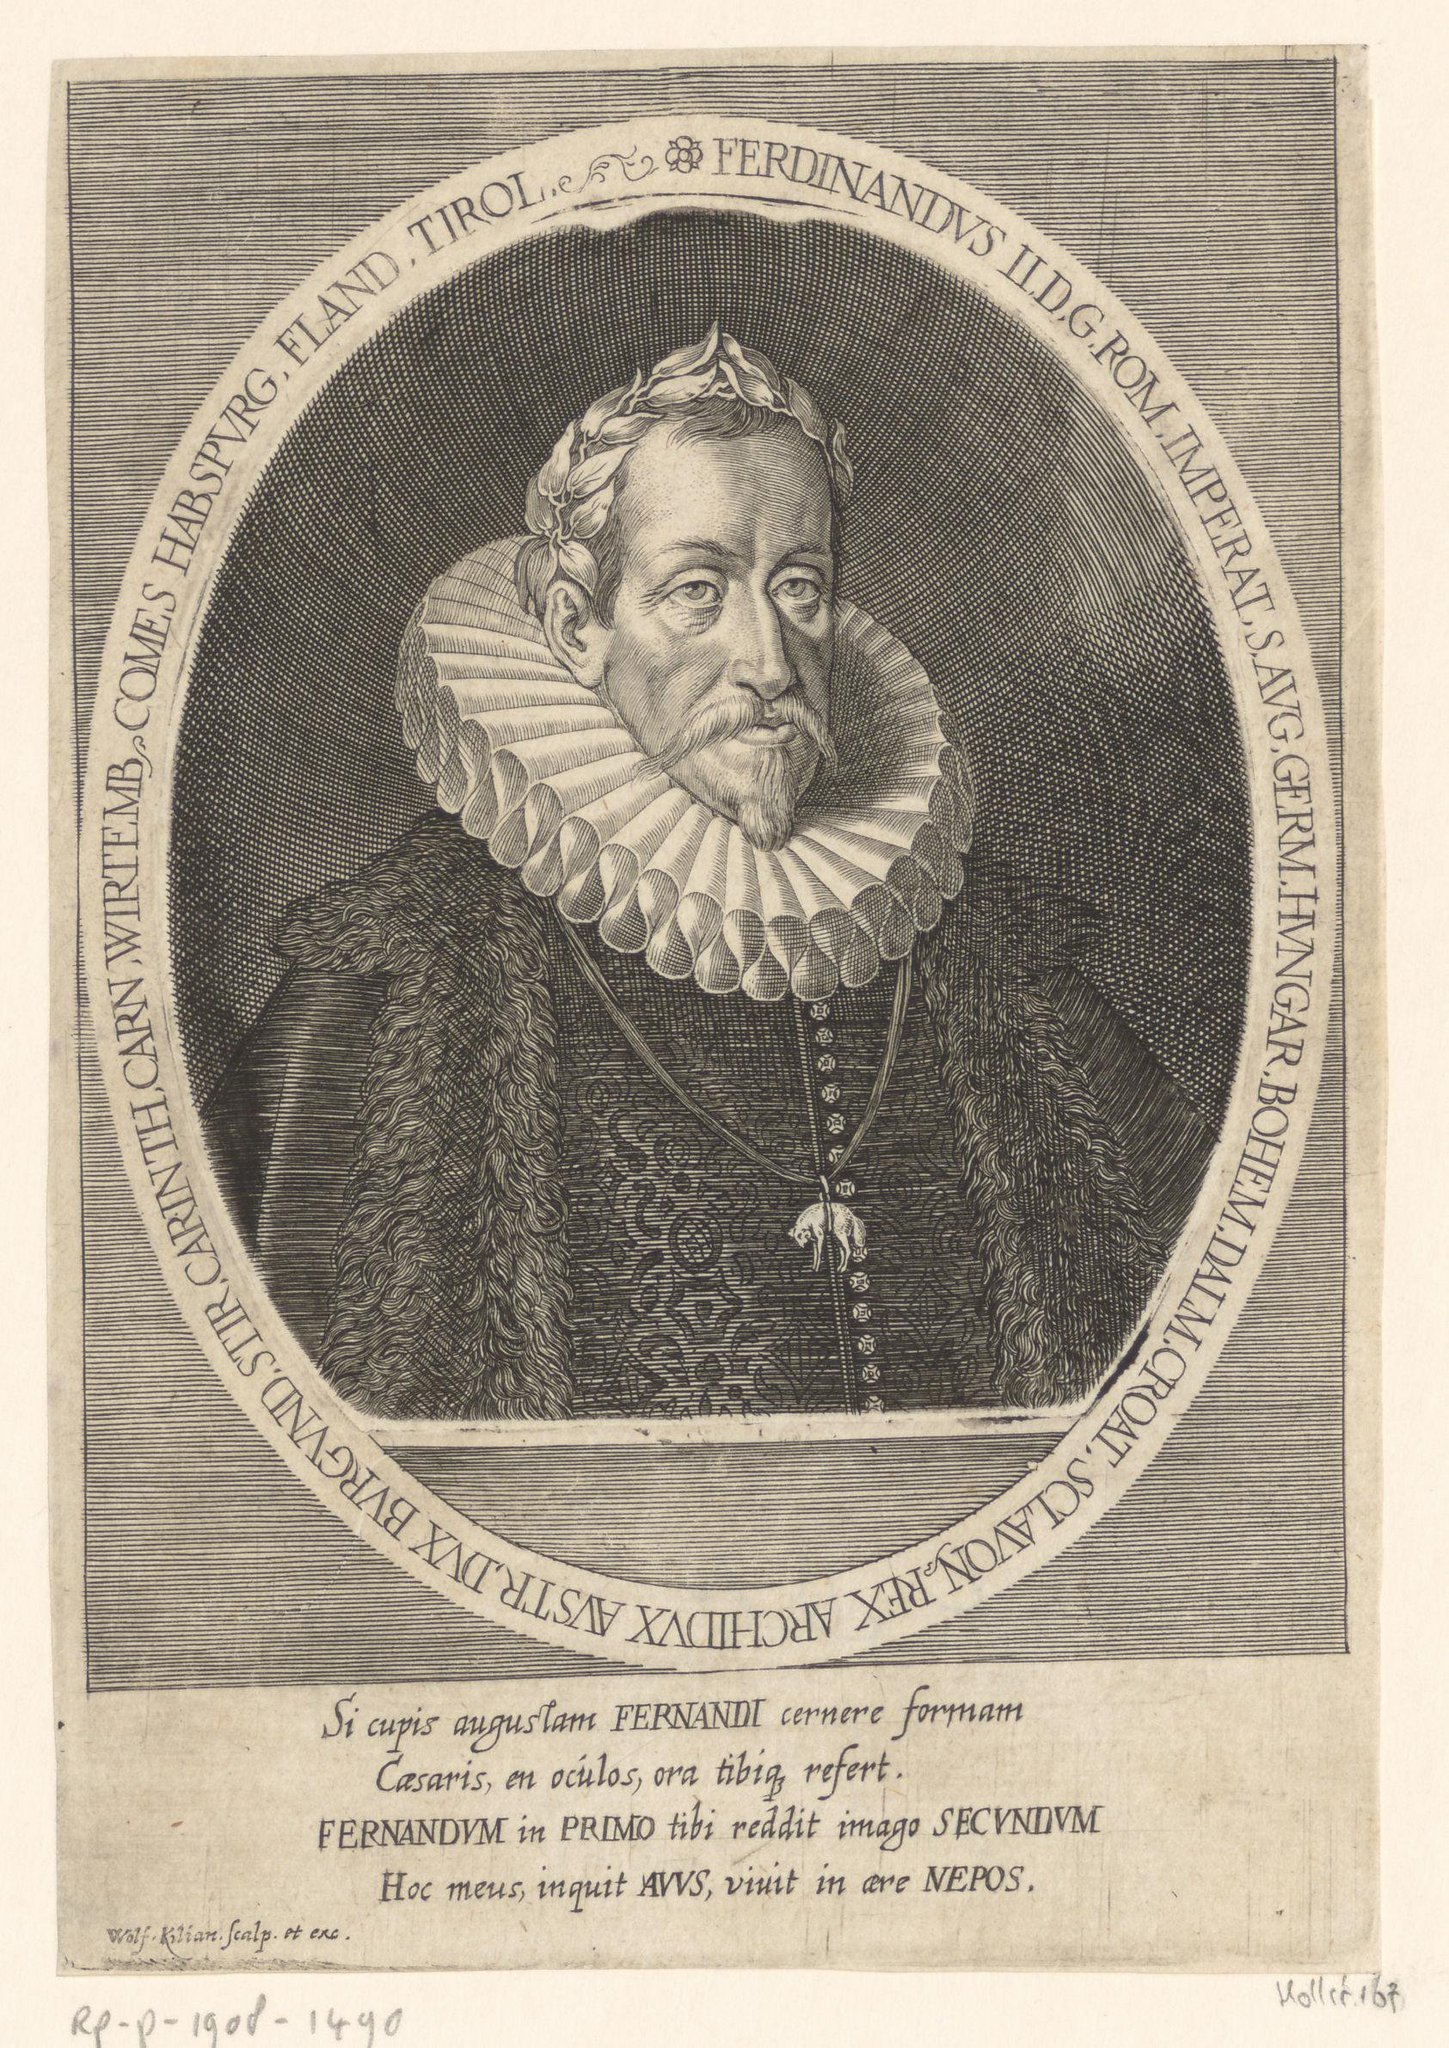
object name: print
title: Portret van keizer Ferdinand II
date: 1619-1662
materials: paper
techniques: engraving, etching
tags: vienna, ferdinand ii (duits keizer), historical persons, knighthood order of the golden fleece, ruler, sovereign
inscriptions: collector's mark: Lugt 2228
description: Tekst in het Latijn in de omlijsting en in de ondermarge.